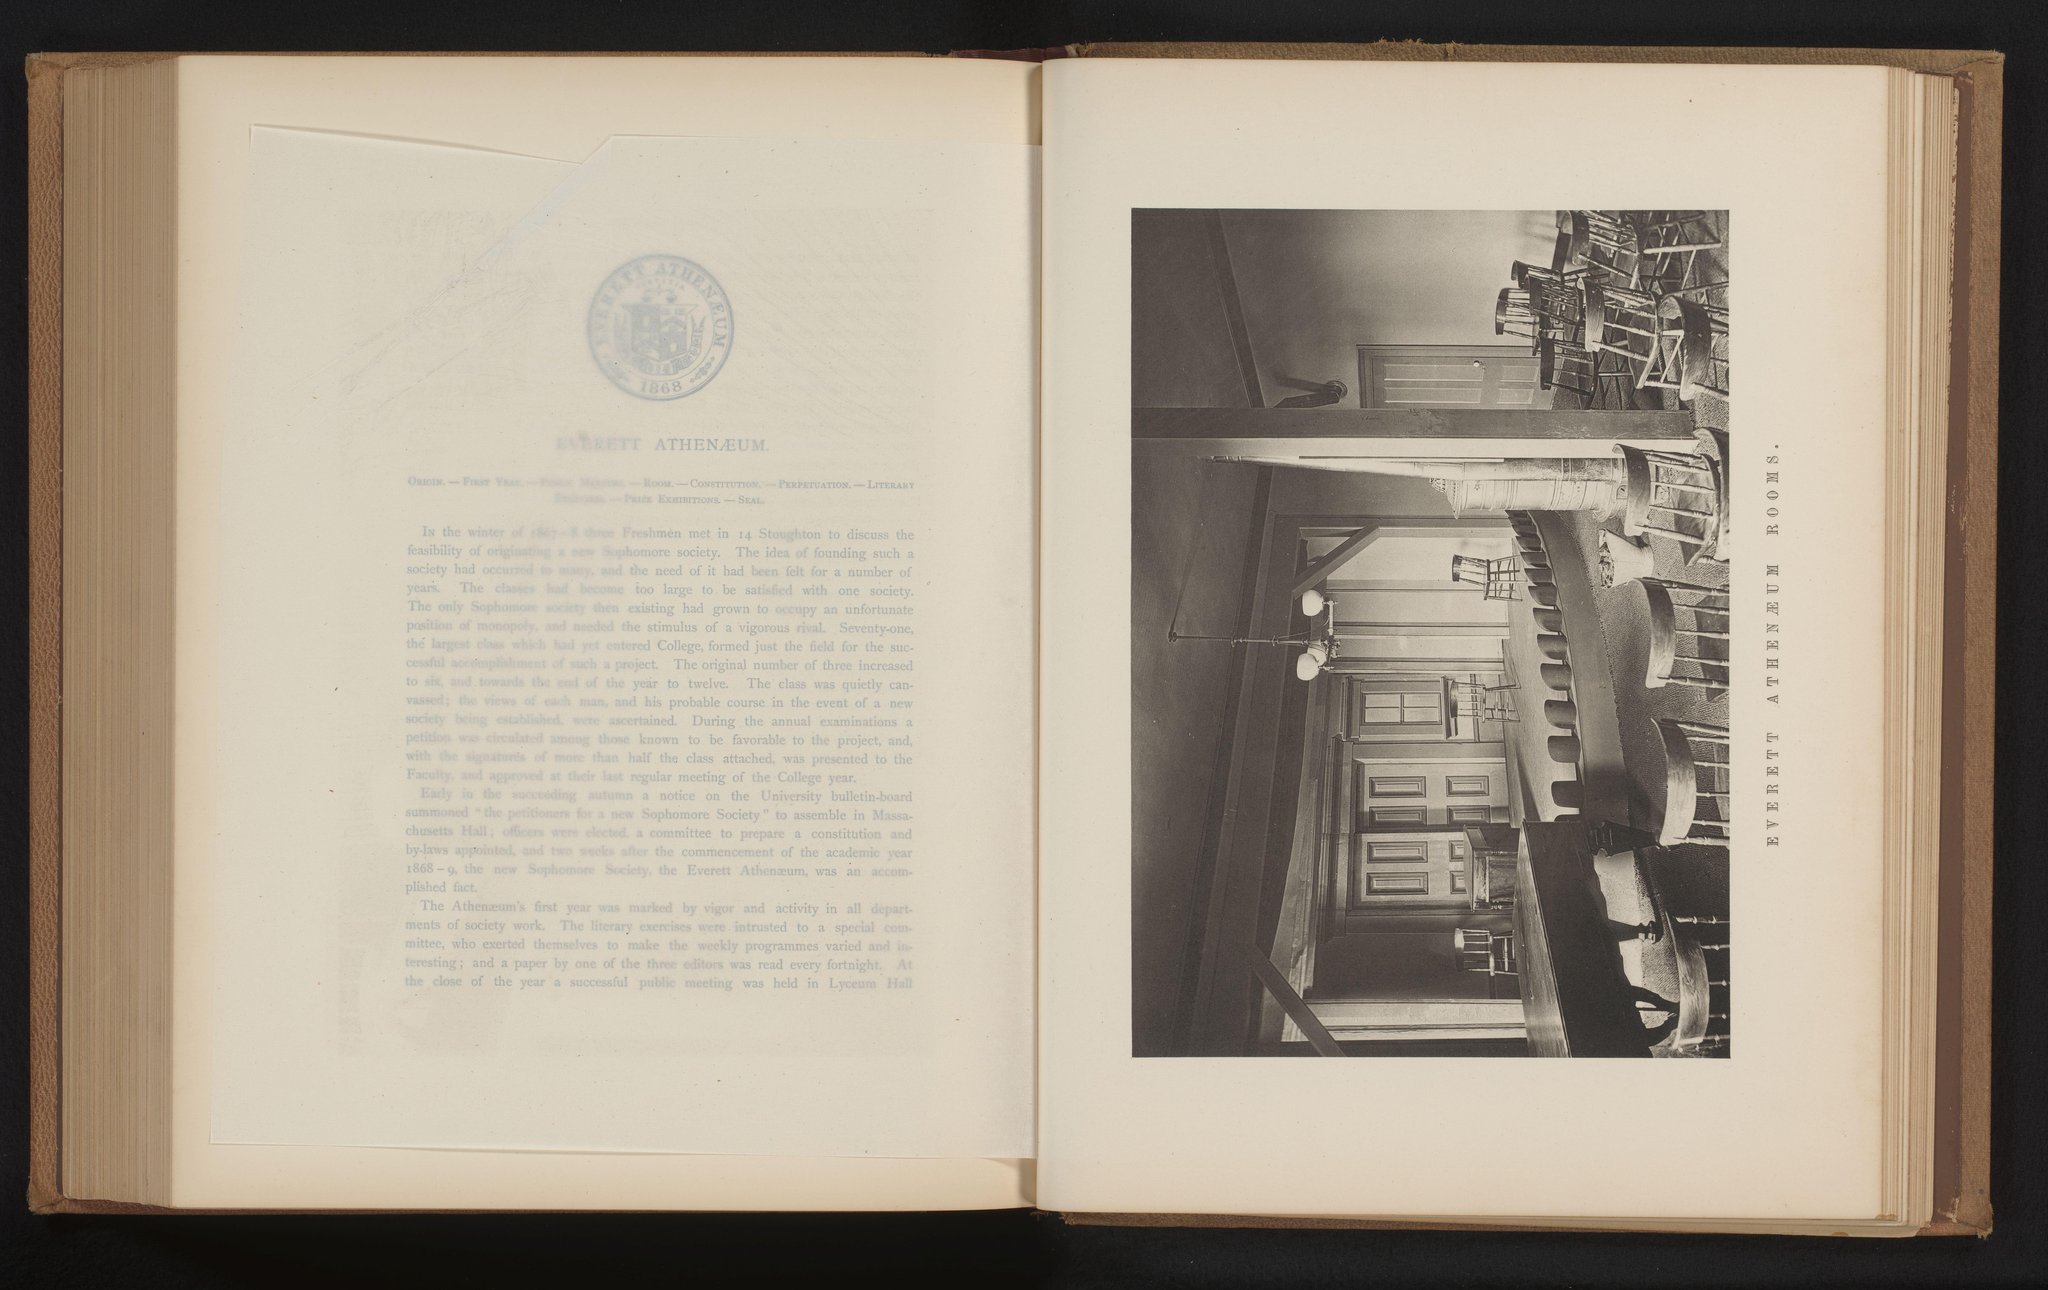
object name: photomechanical print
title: Everett Athenaeum rooms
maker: Anonymous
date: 1870-1875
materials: paper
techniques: photograph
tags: club (students)